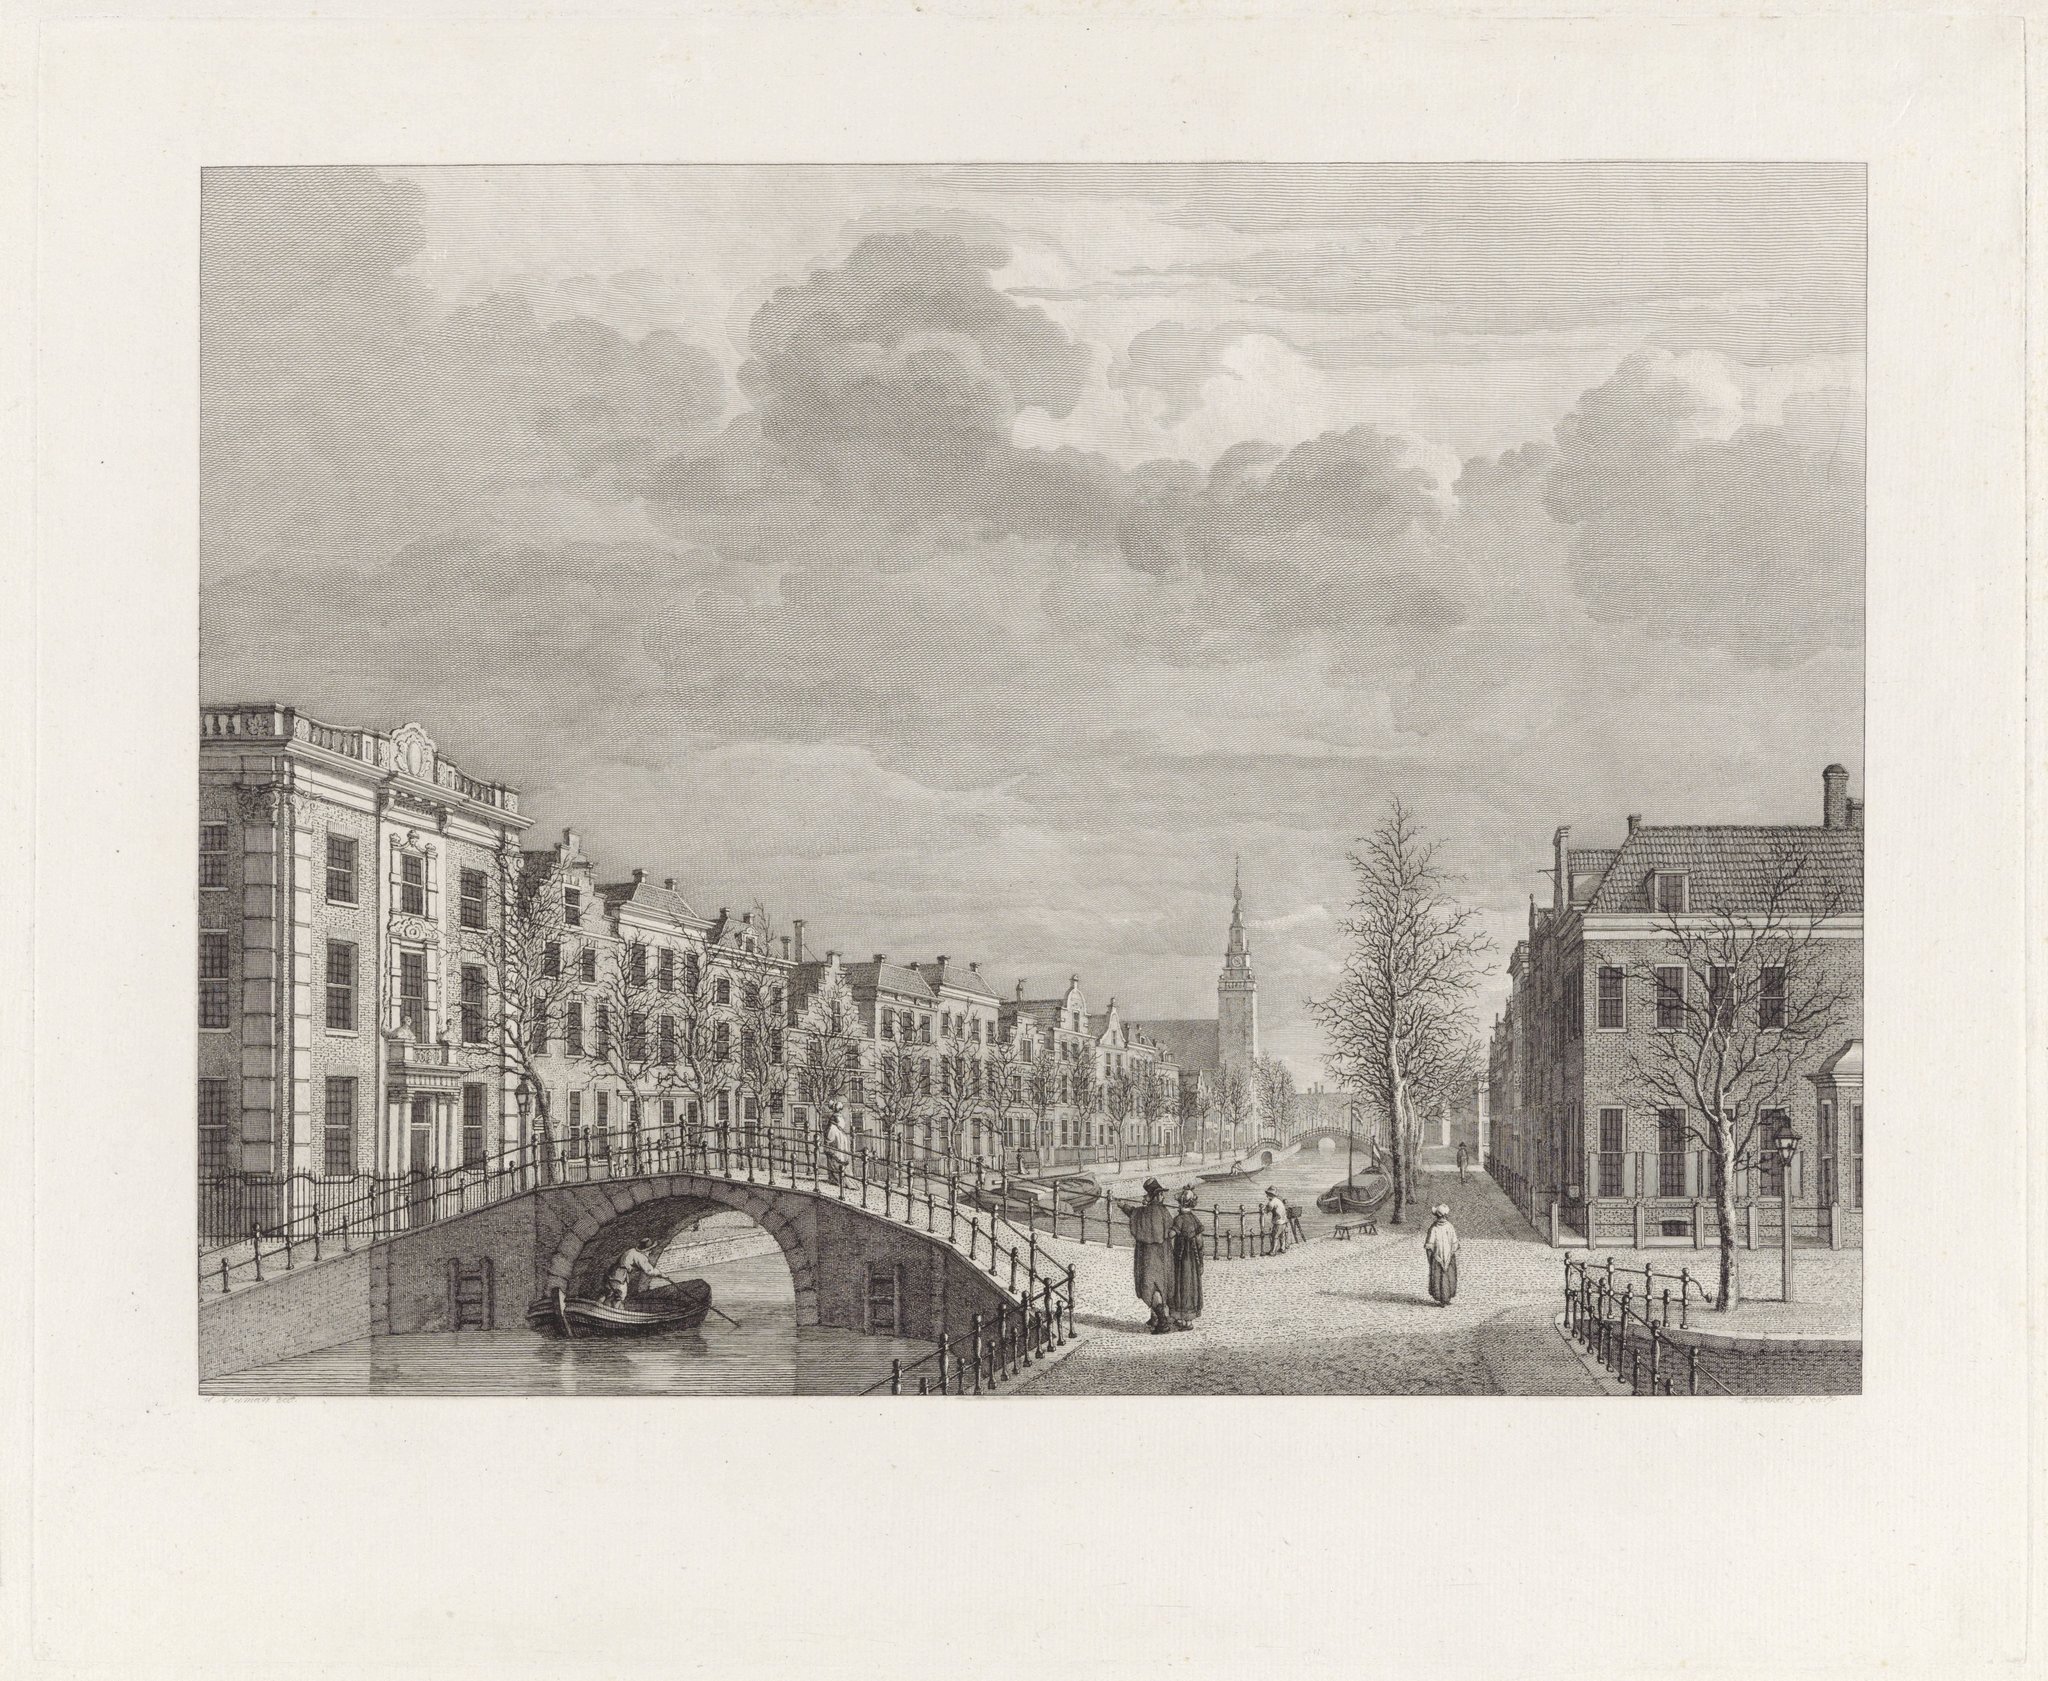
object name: print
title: Gezicht op het Rapenburg te Leiden van de Nieuwsteegbrug, 1807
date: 1807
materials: paper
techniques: engraving, etching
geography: amsterdam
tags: city-view in general; 'veduta'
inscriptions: collector's mark: Lugt 2228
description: Gezicht op het Steenschuur, een gracht in het verlengde van het Rapenburg, te Leiden, in welstand vóór de buskruitramp van 12 januari 1807. Links op de voorgrond de Nieuwsteegbrug met daarachter het Steenschuur. Links op de hoek van het Steenschuur het huis van schepen J.W. van Noort. Op de achtergrond de Saaihal (de latere Sint-Lodewijkskerk).